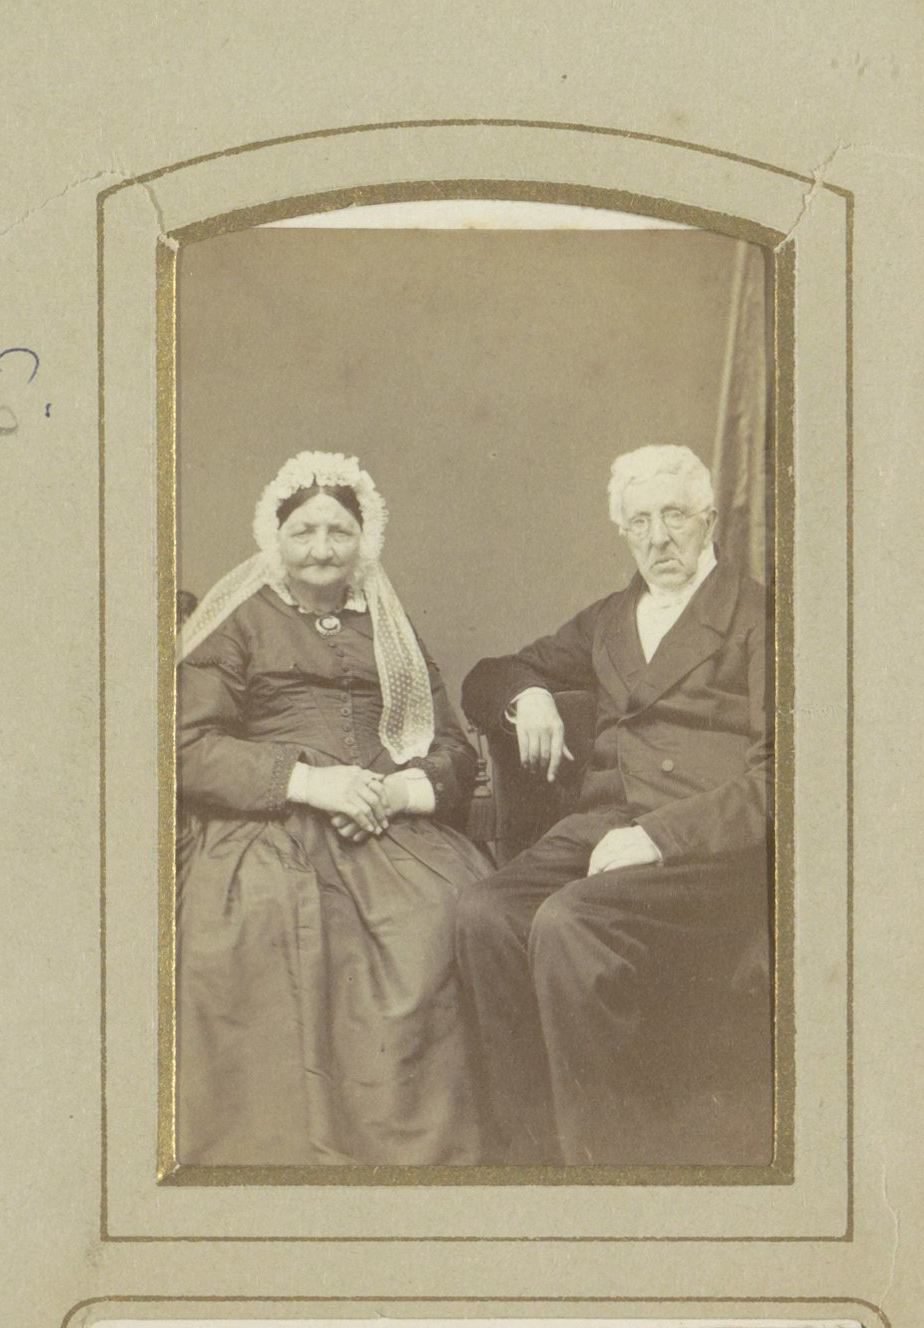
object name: carte de visite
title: Portret van een ouder echtpaar, mogelijk Schmidt van Gelder-Eindhoven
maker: Anonymous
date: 1860-1890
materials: cardboard, paper, photographic support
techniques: albumen print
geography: netherlands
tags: historical persons, marriage, married couple, 'matrimonium', netherlands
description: Onderdeel van Fotoalbum van de familie Boelen.